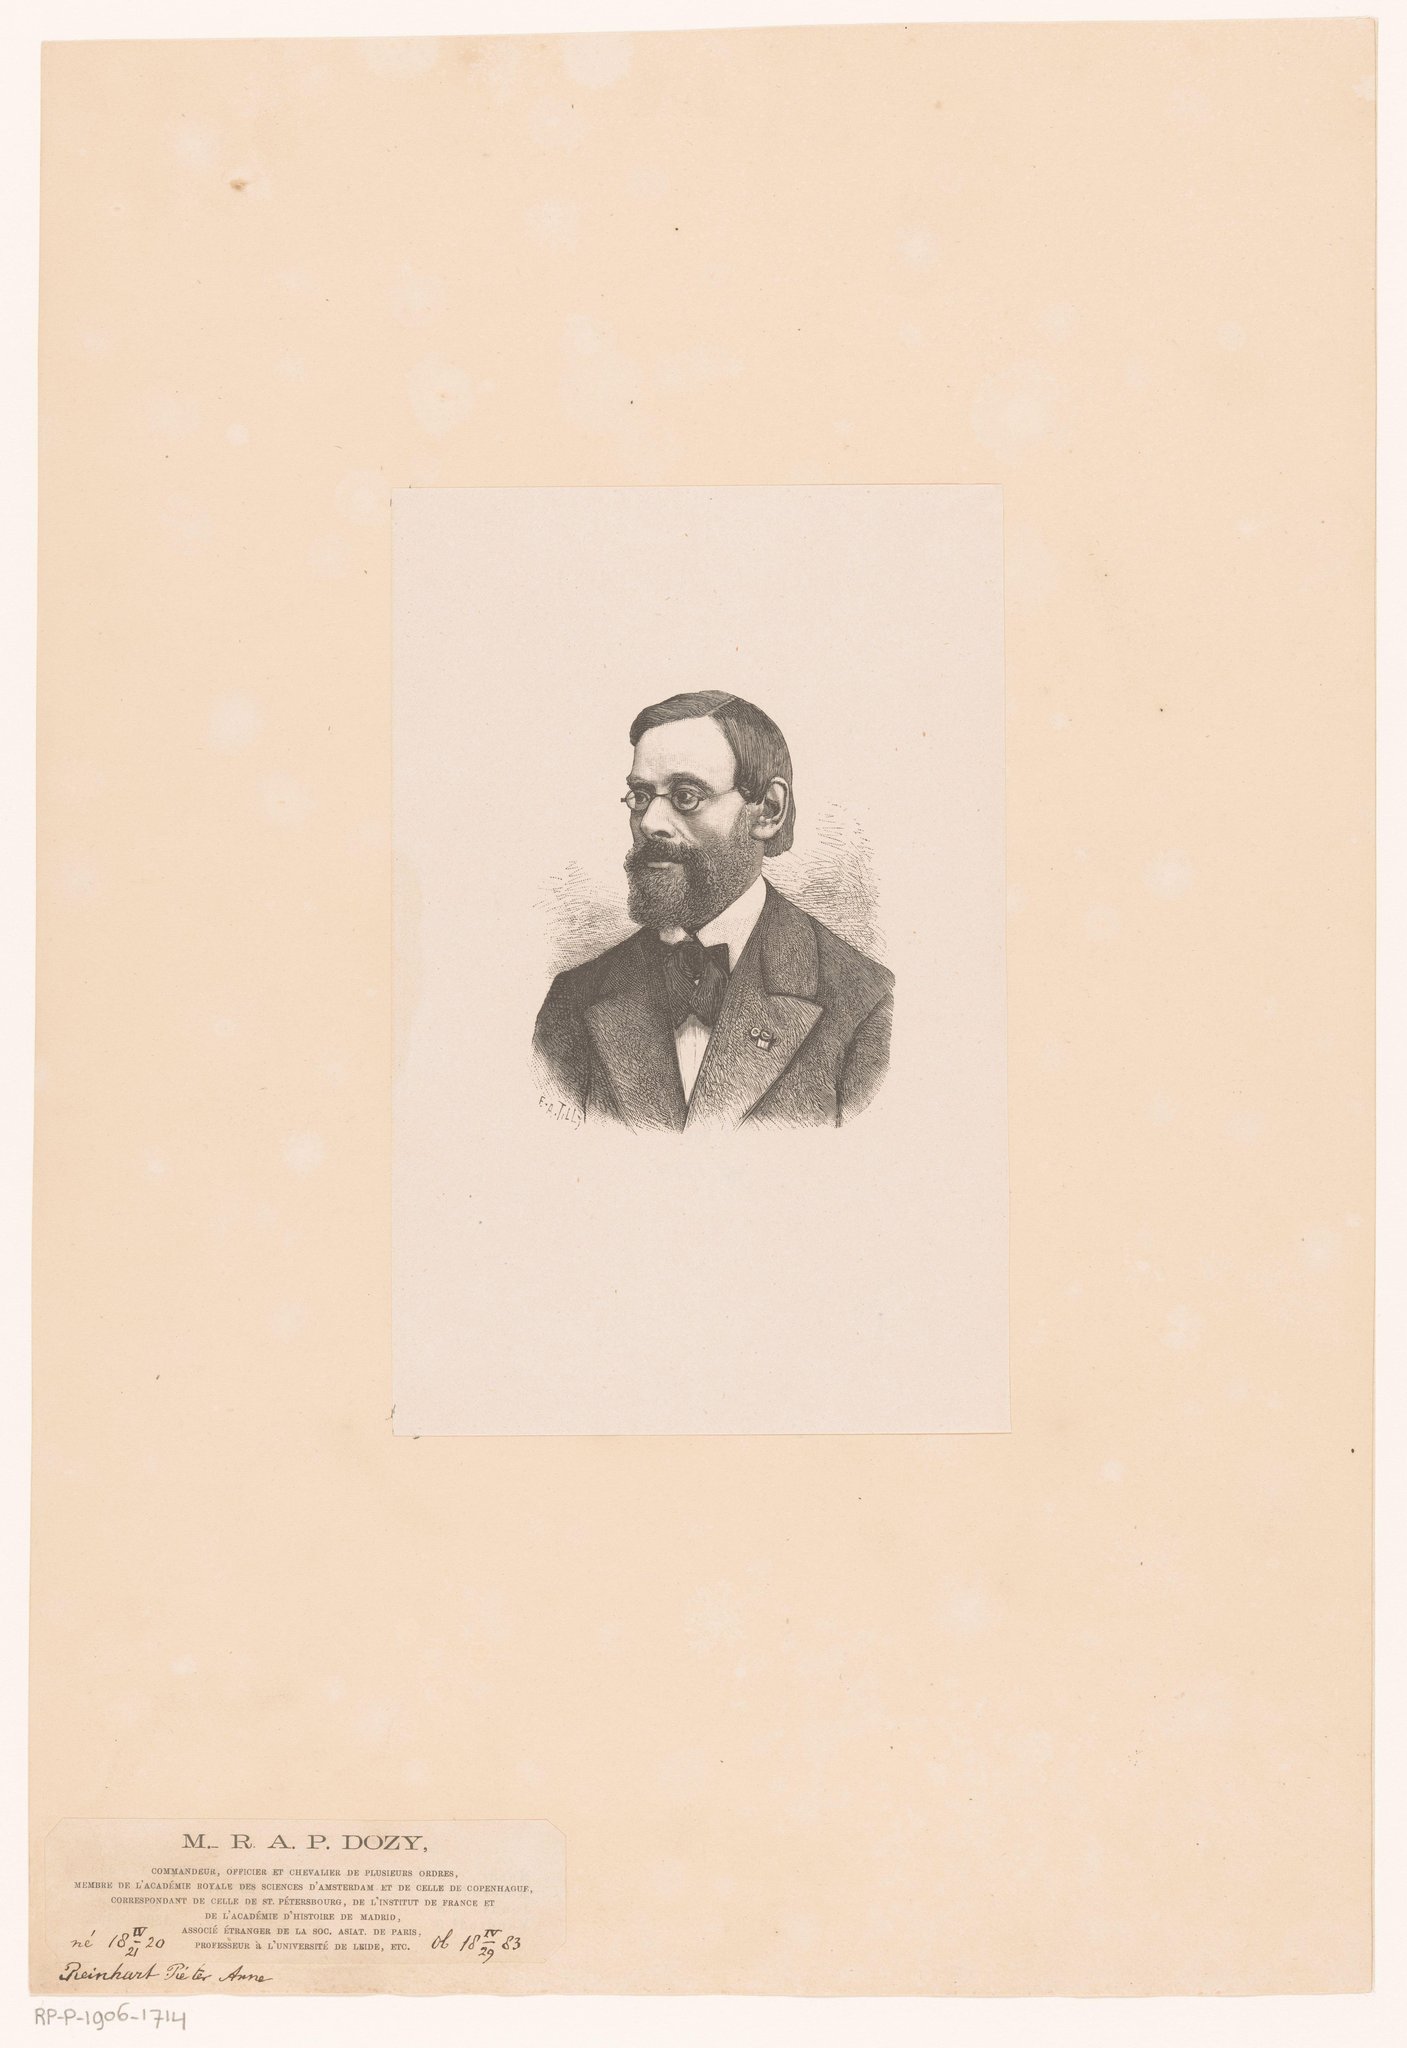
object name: print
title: Portret van Reinhart Pieter Anne Dozy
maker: auguste tilly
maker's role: print maker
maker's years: 1840-1898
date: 1850-1898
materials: paper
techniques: engraving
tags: leiden, historical persons, professor